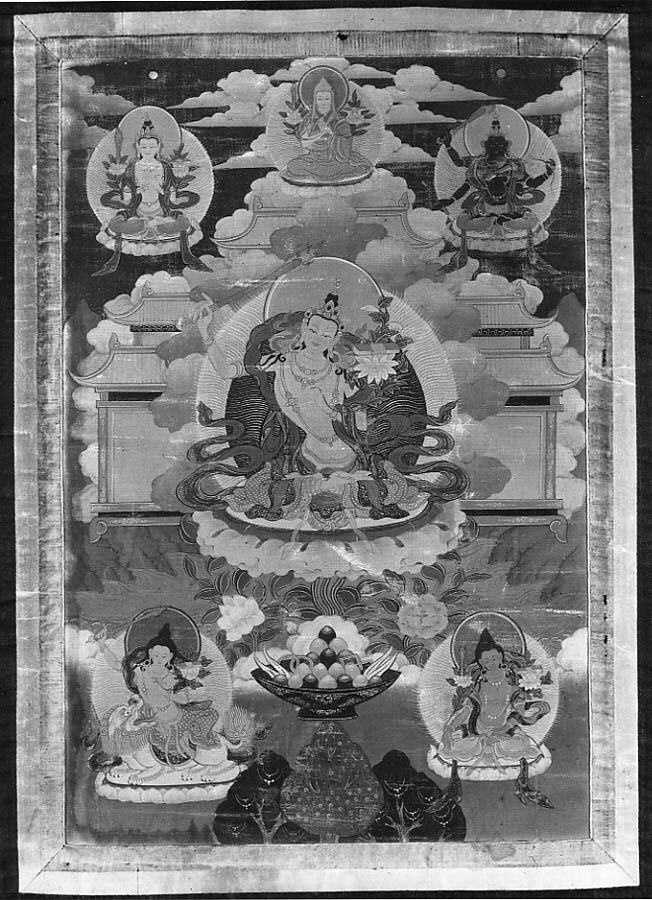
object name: thangka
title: Manjushri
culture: tibetan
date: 1601-1800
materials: gold, hemp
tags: manjushri